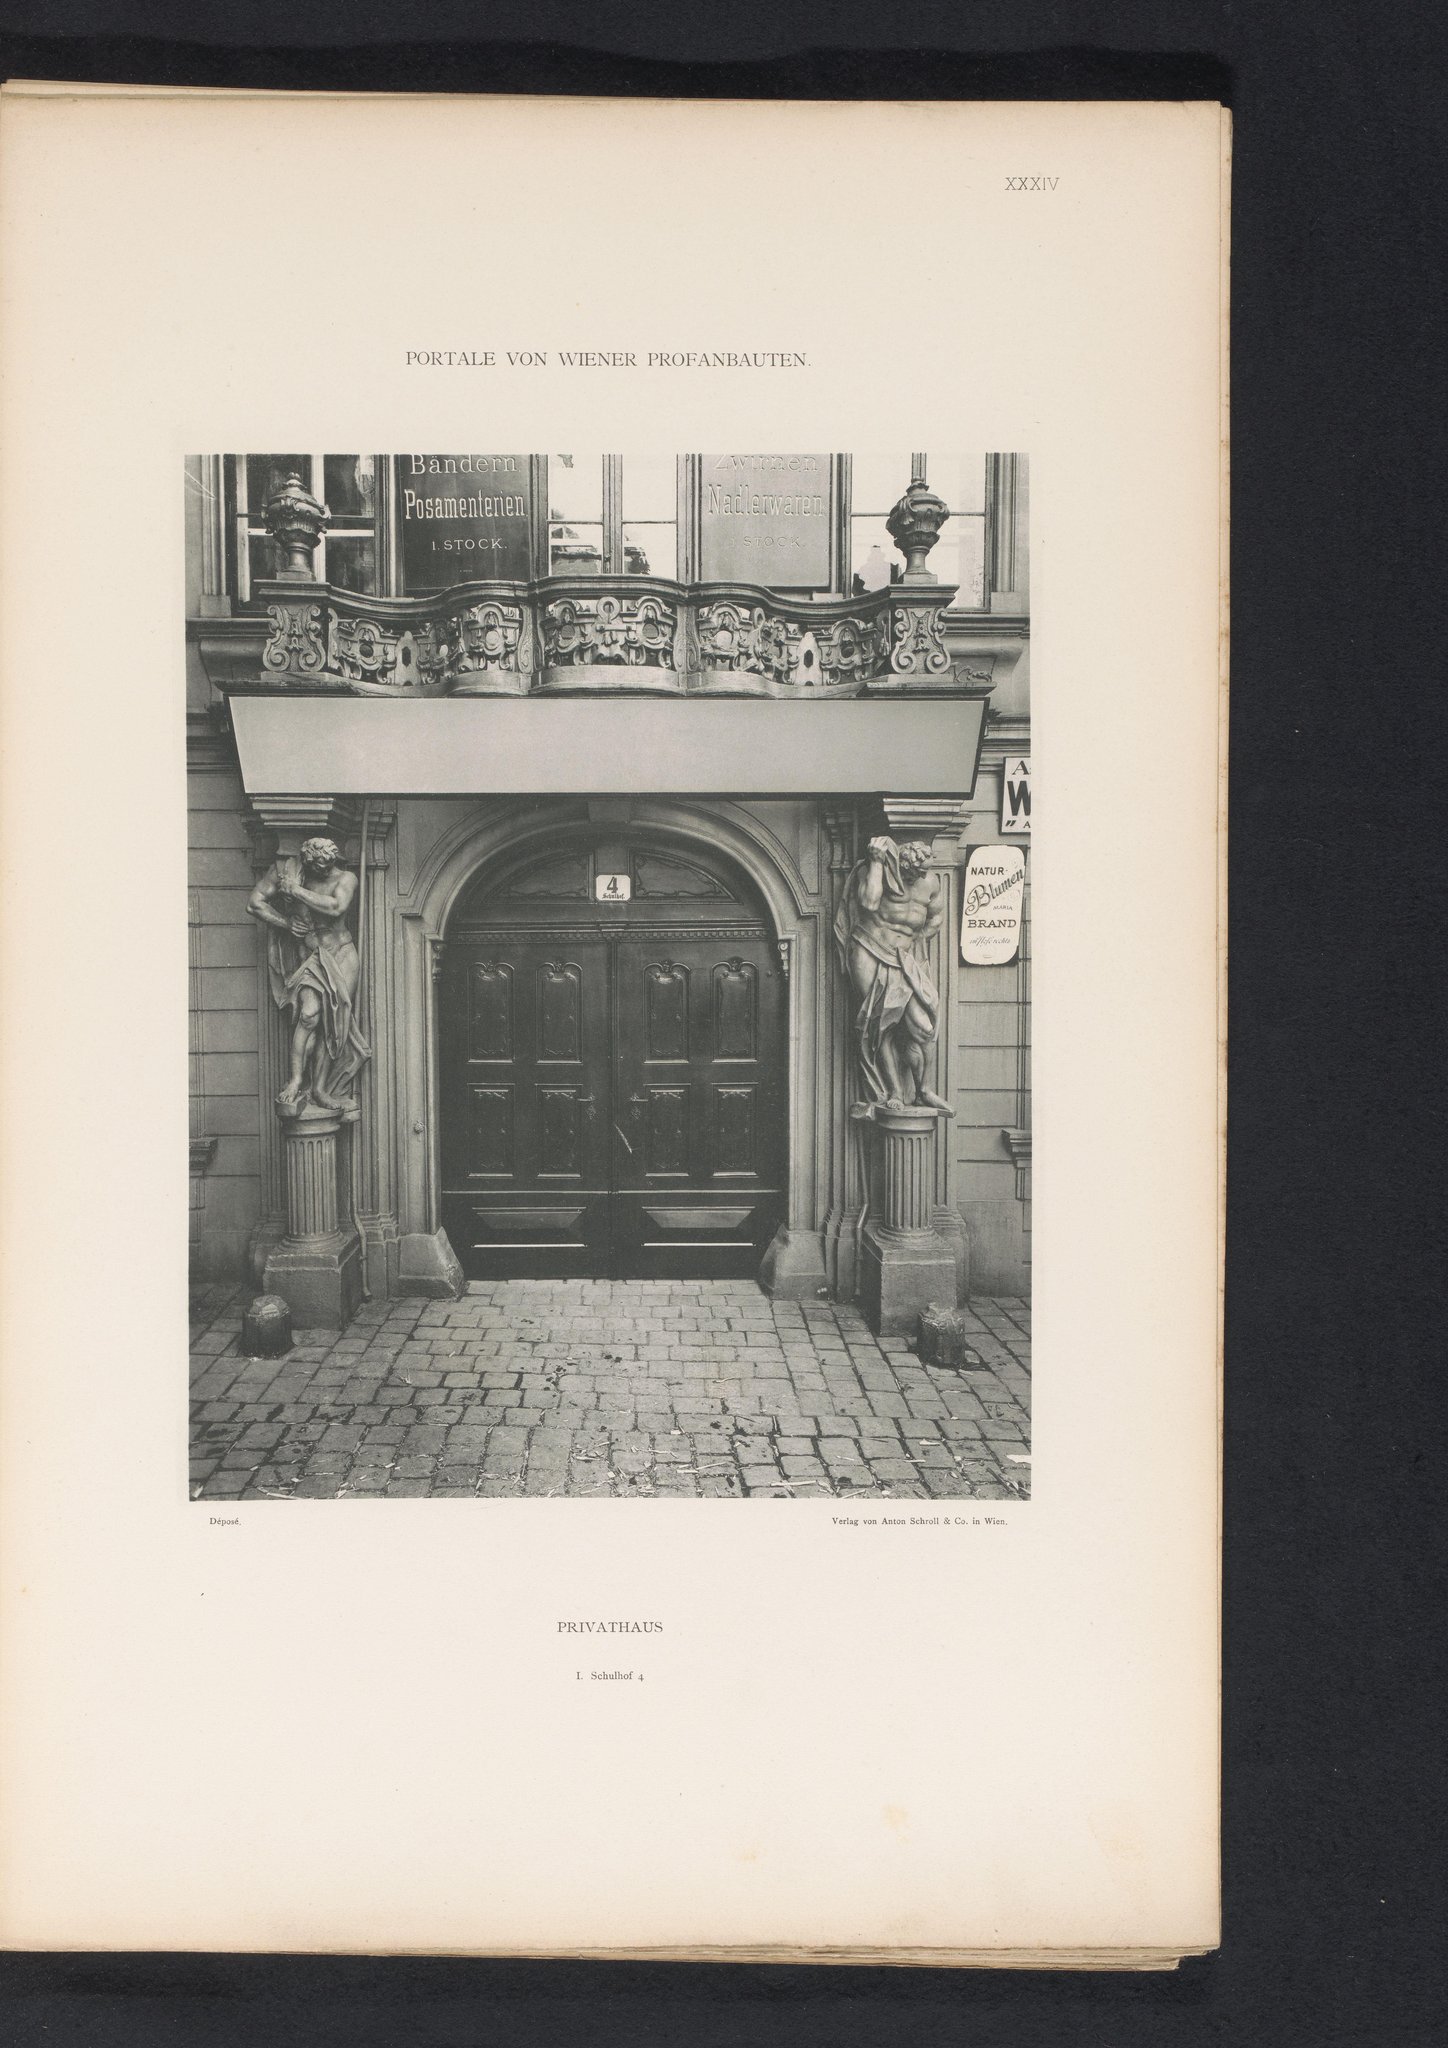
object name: page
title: Privathaus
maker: Anonymous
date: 1884-1894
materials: paper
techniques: photograph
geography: vienna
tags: atlantes ~ architecture, gate, entrance, façade (of house or building)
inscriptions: number: ‘XXXIV.’, inscription: ‘I. Schulhof 4’